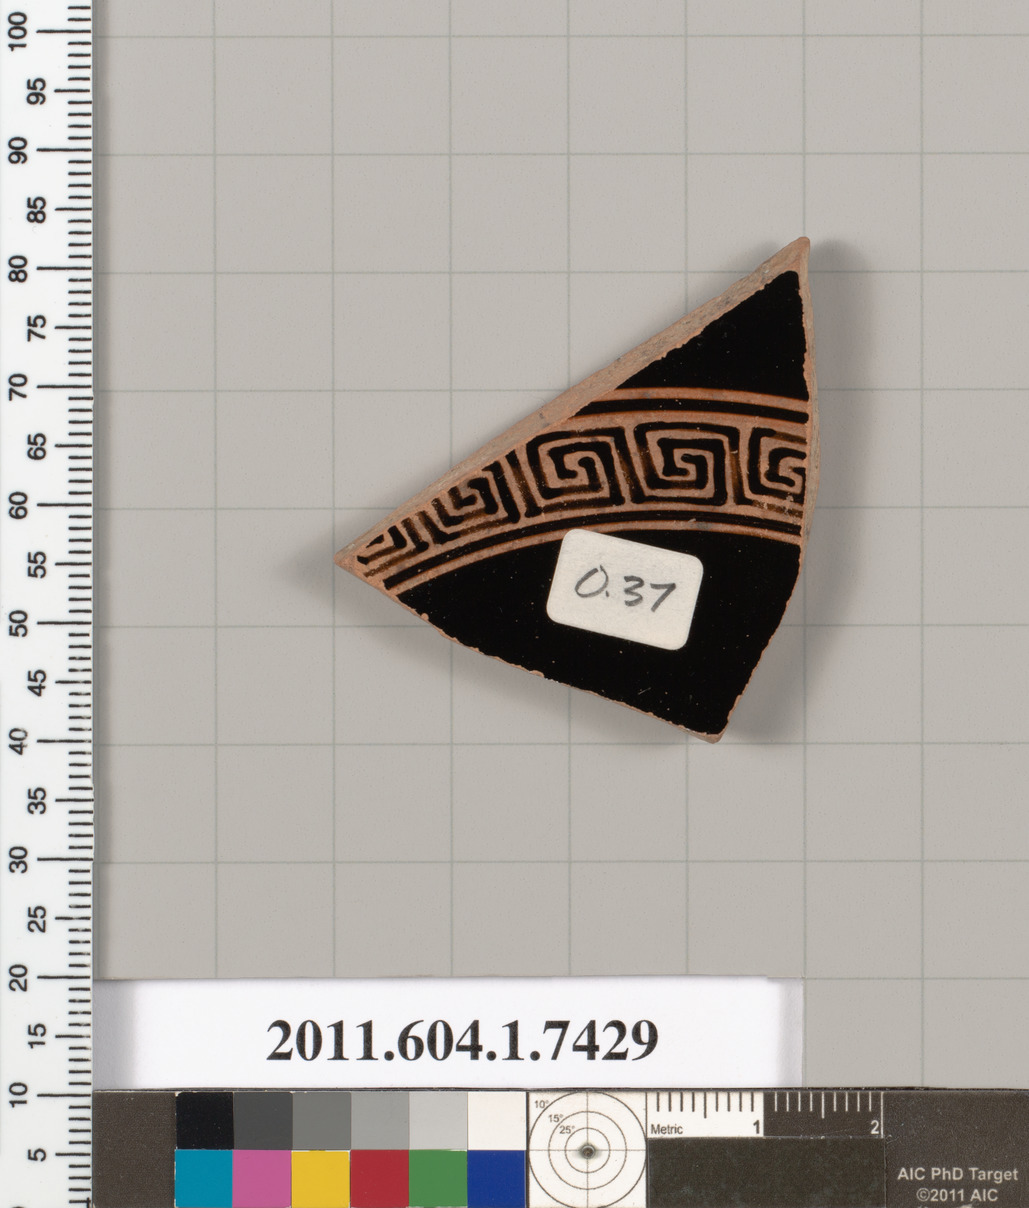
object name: kylix fragment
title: Terracotta fragment of a kylix (drinking cup)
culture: greek, attic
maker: telephos painter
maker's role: artist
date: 480-470 BCE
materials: terracotta